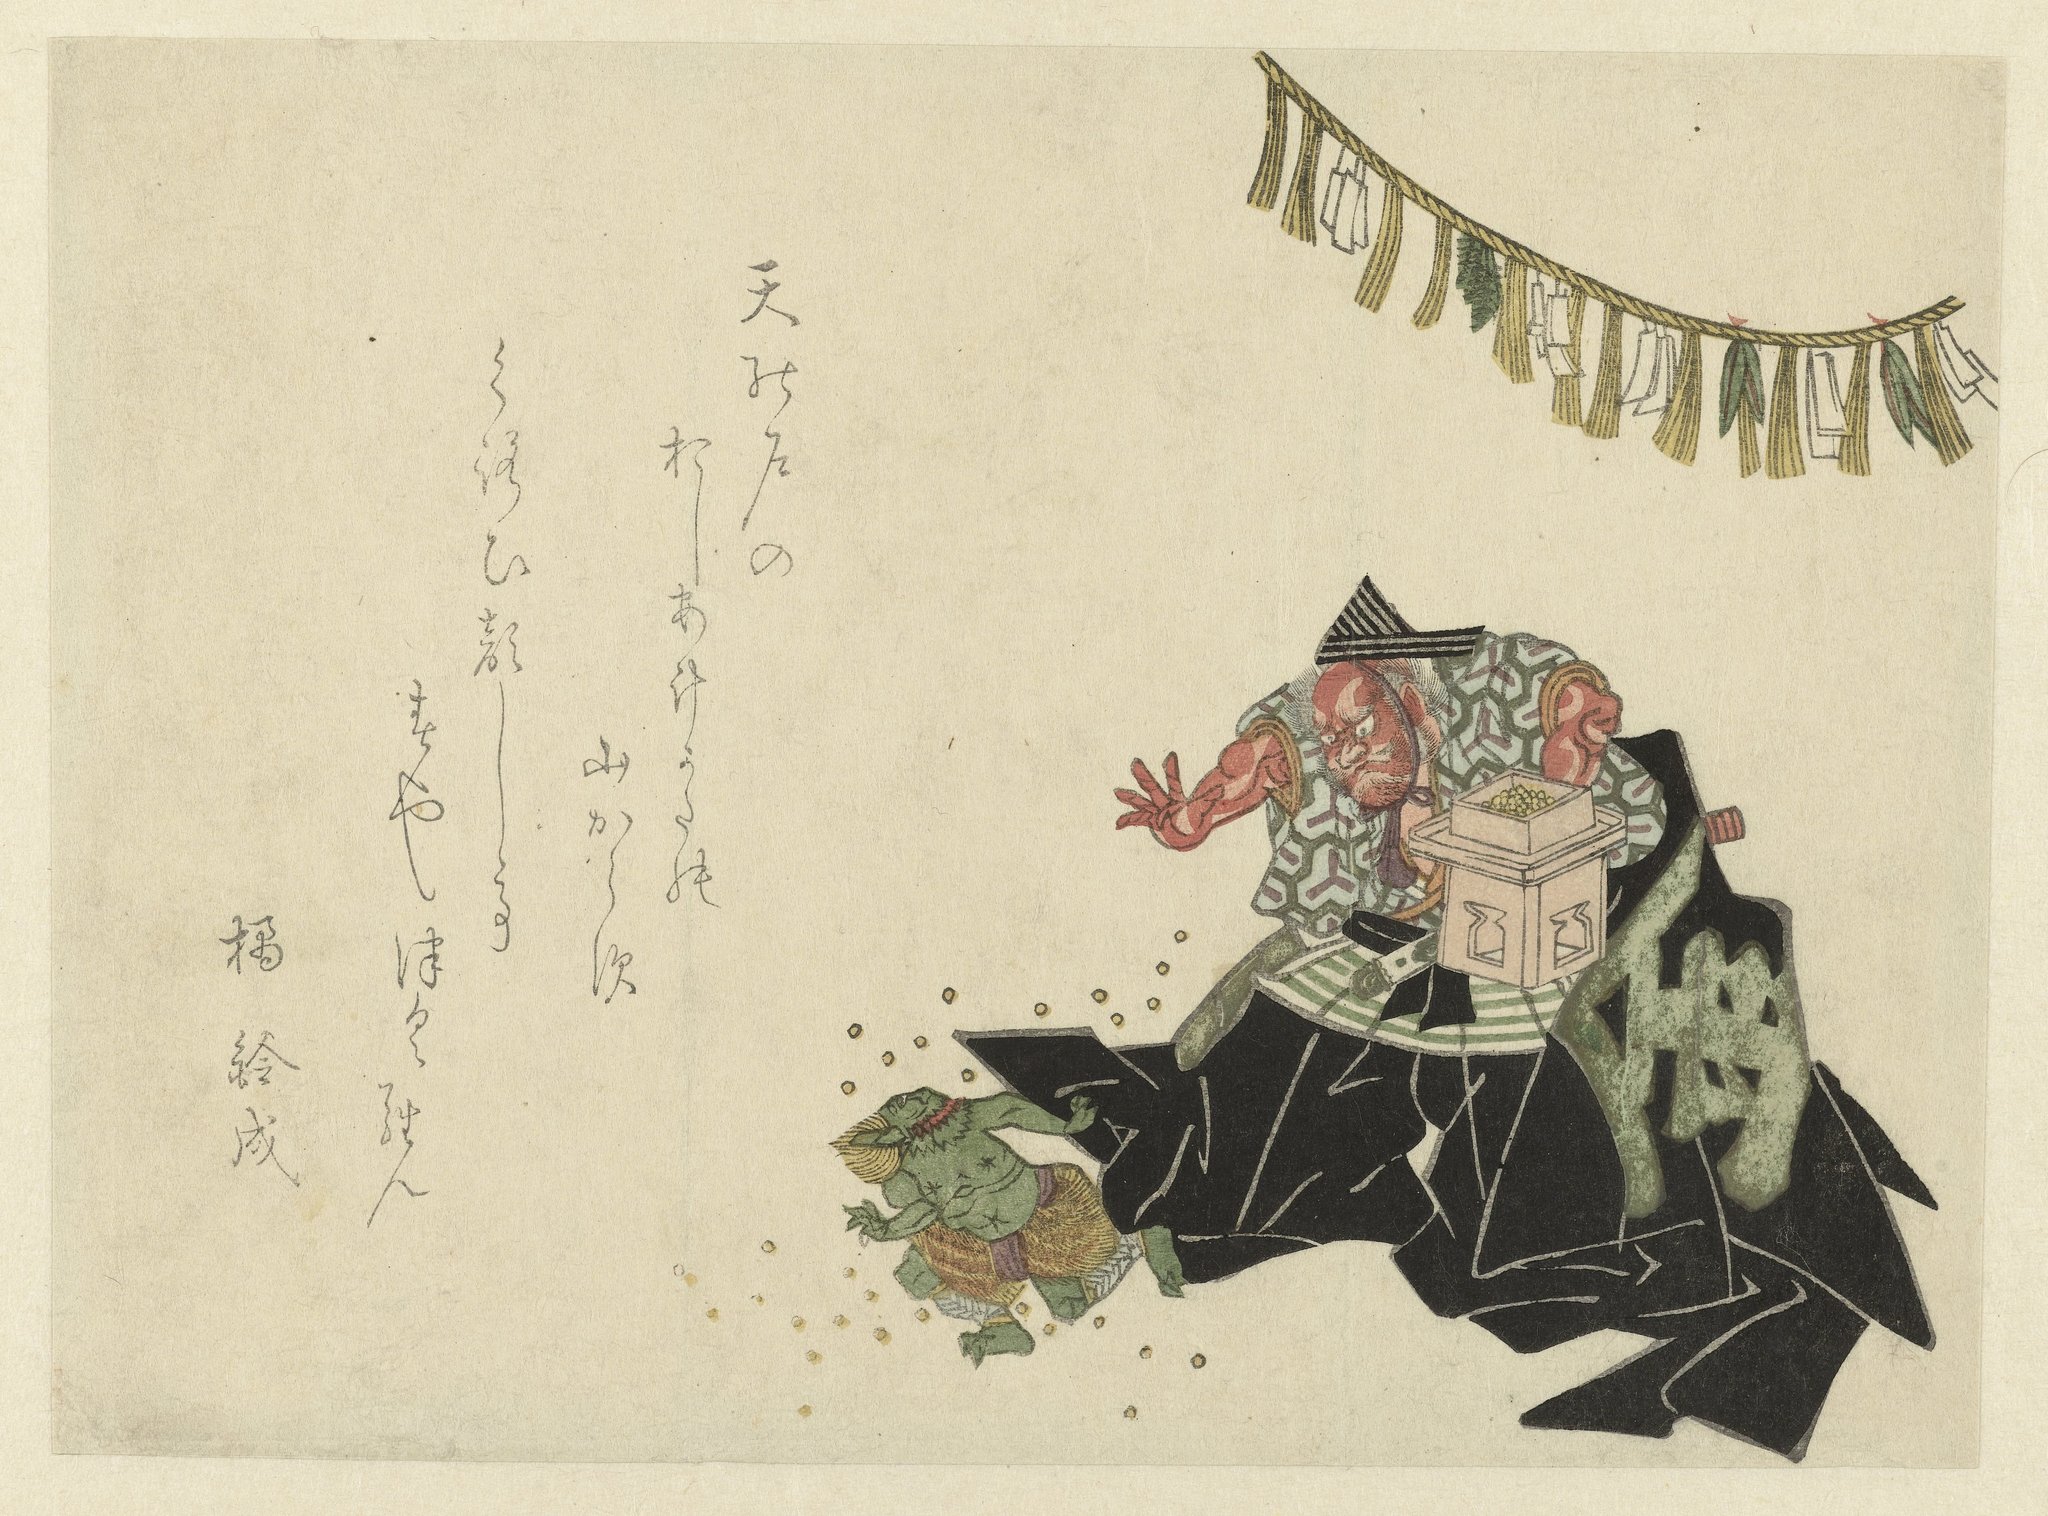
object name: surimono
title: Kintoki Chasing a Demon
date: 1815-1820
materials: paper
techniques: woodcut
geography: japan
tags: demons ~ non-christian religions, plants and herbs: bean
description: Een surimono is een luxe uitgevoerde prent waarop beeld met één of meerdere gedichten gecombineerd is. Bij het drukken van een surimono werd vaak gebruik gemaakt van dikker papier, blinddruk en metaal pigmenten, zoals koper- en zilverpoeder. De prenten werden vaak in opdracht van dichters gemaakt en als exclusief geschenk aan vrienden en relaties gegeven.